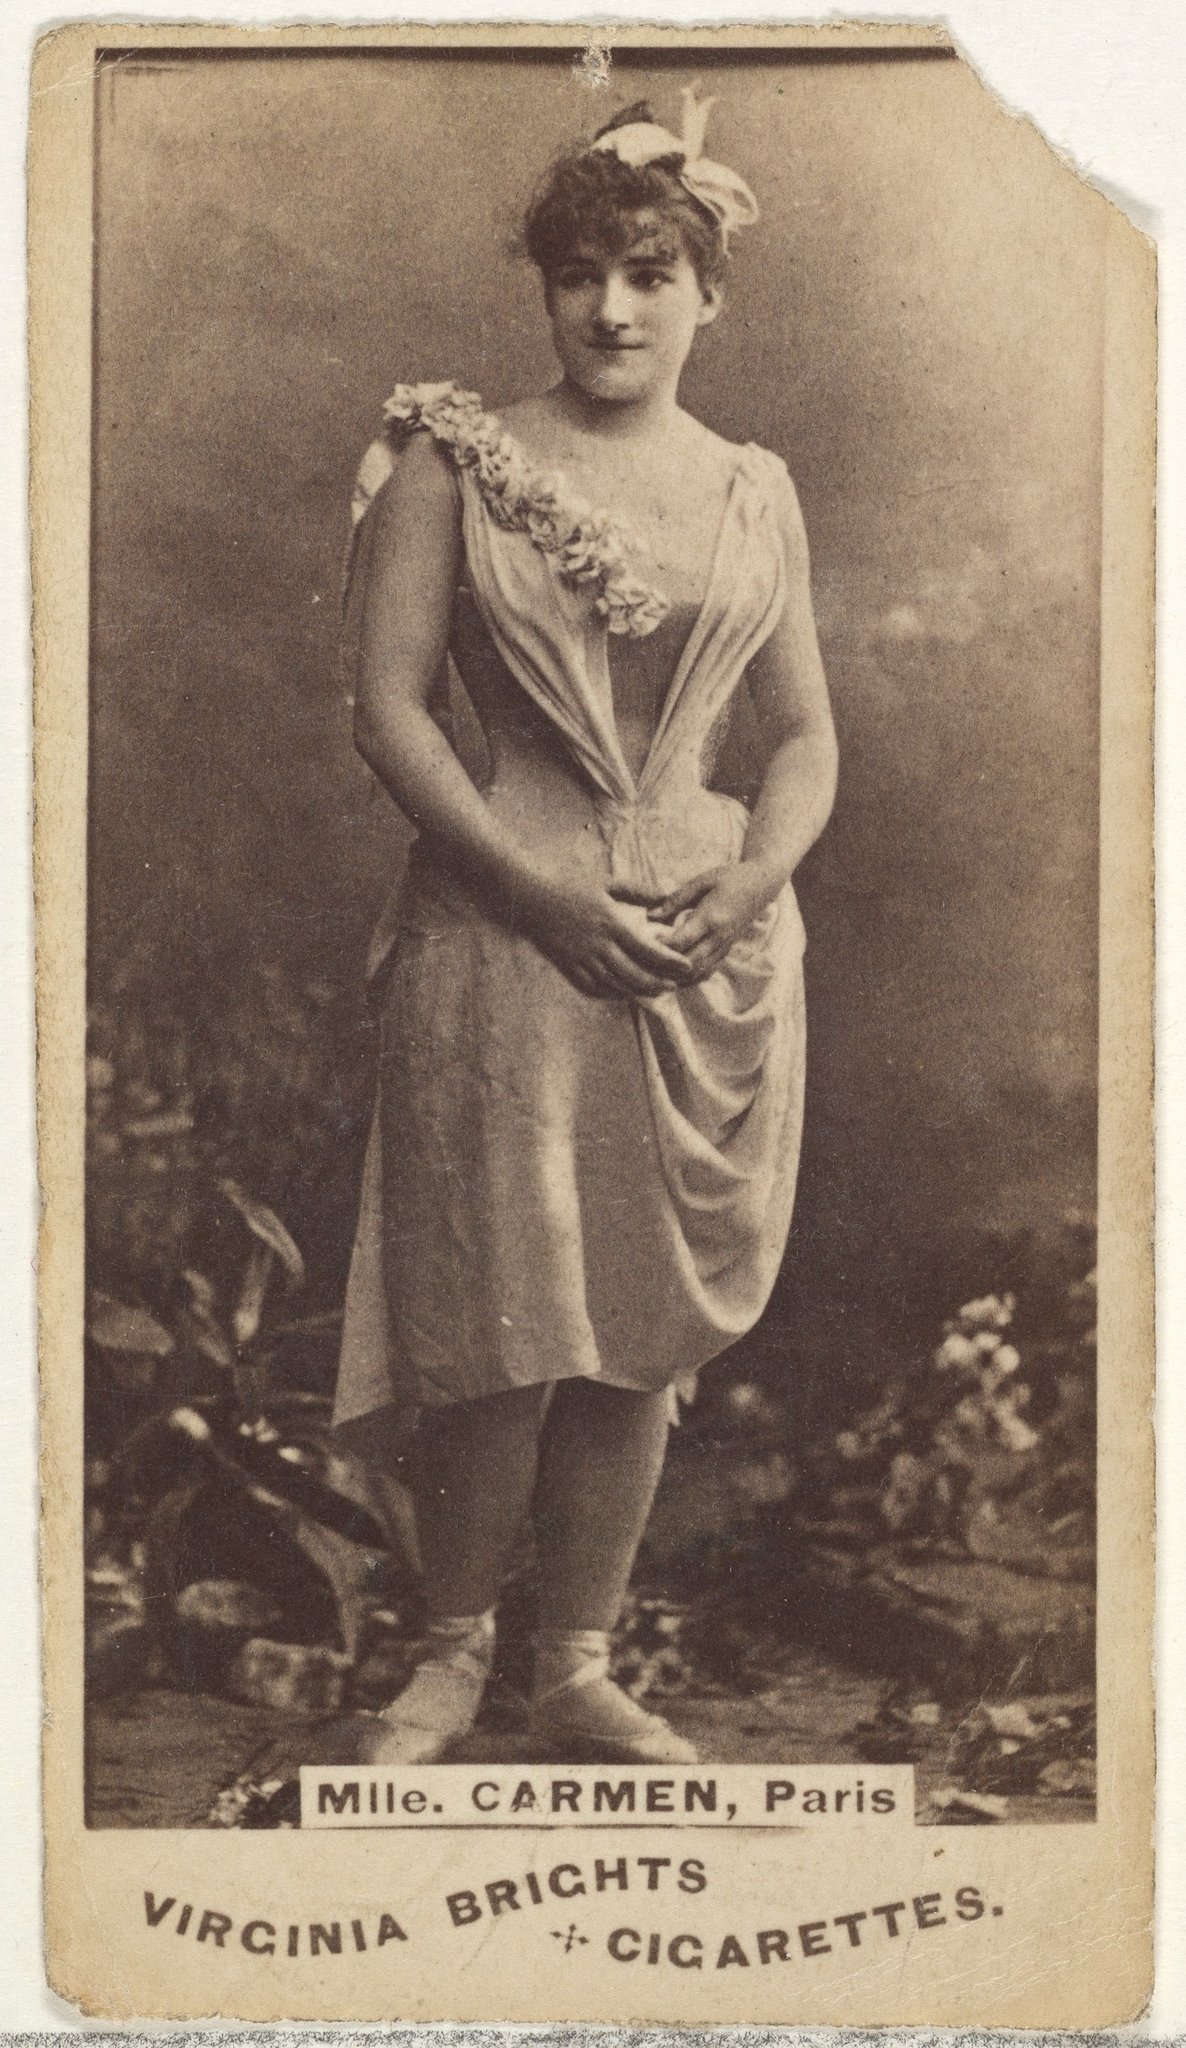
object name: photograph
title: Mlle. Carmen, Paris, from the Actors and Actresses series (N45, Type 1) for Virginia Brights Cigarettes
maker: allen & ginter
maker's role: publisher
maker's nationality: american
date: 1888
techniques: albumen silver print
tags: portraits,women,actresses